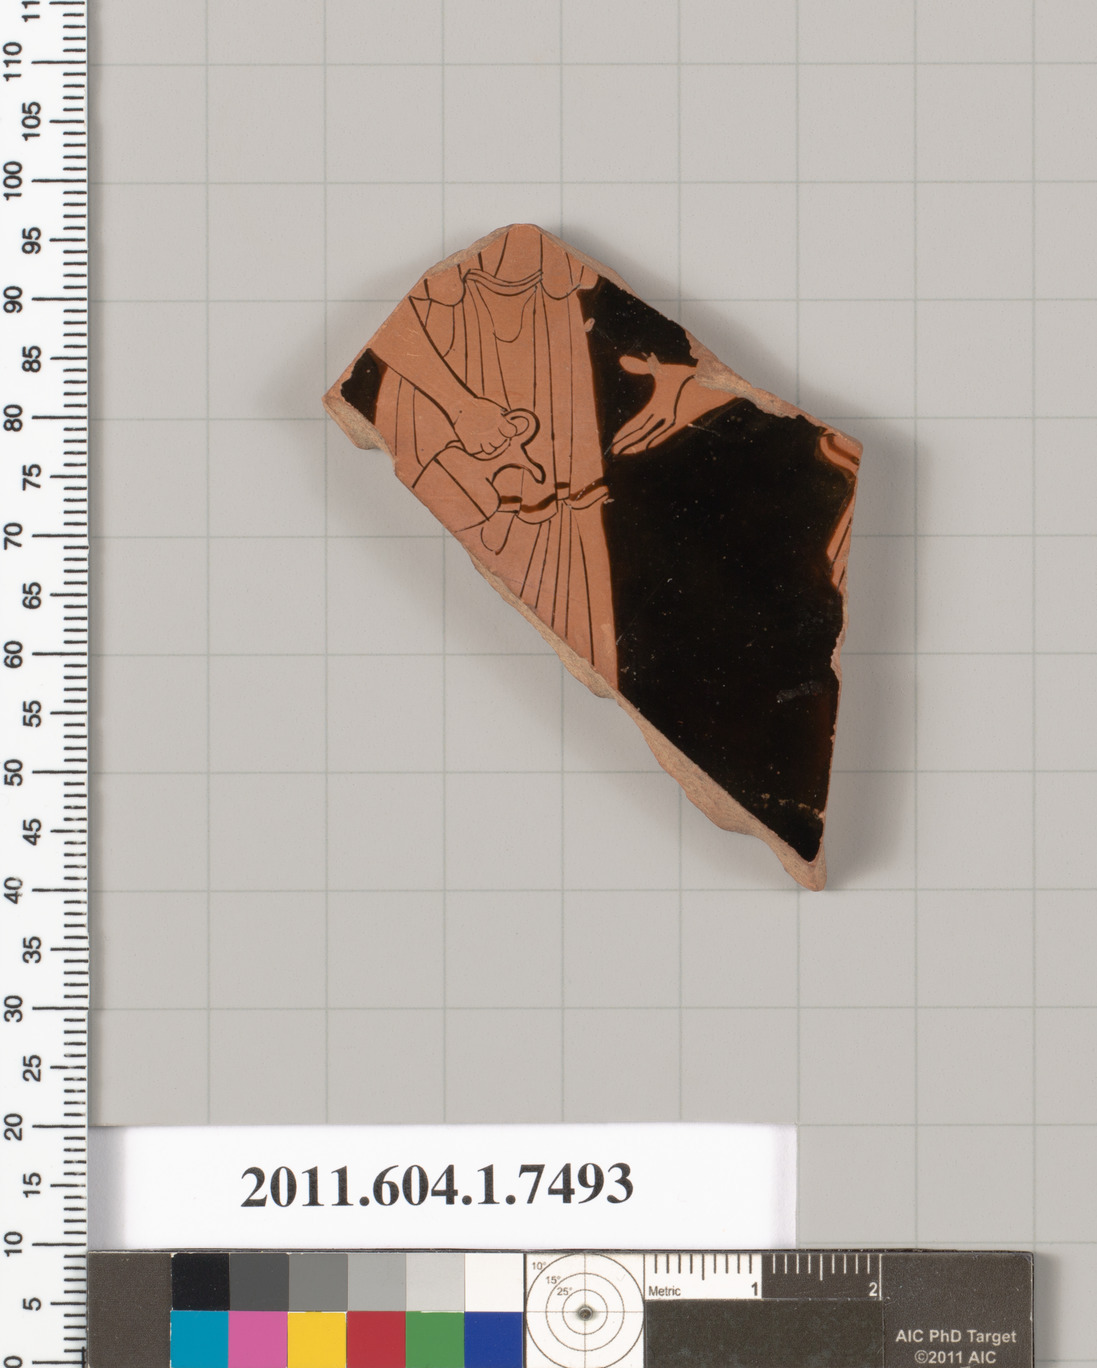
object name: kylix fragment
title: Terracotta fragment of a kylix (drinking cup)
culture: greek, attic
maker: euaion painter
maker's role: artist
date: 460-450 BCE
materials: terracotta